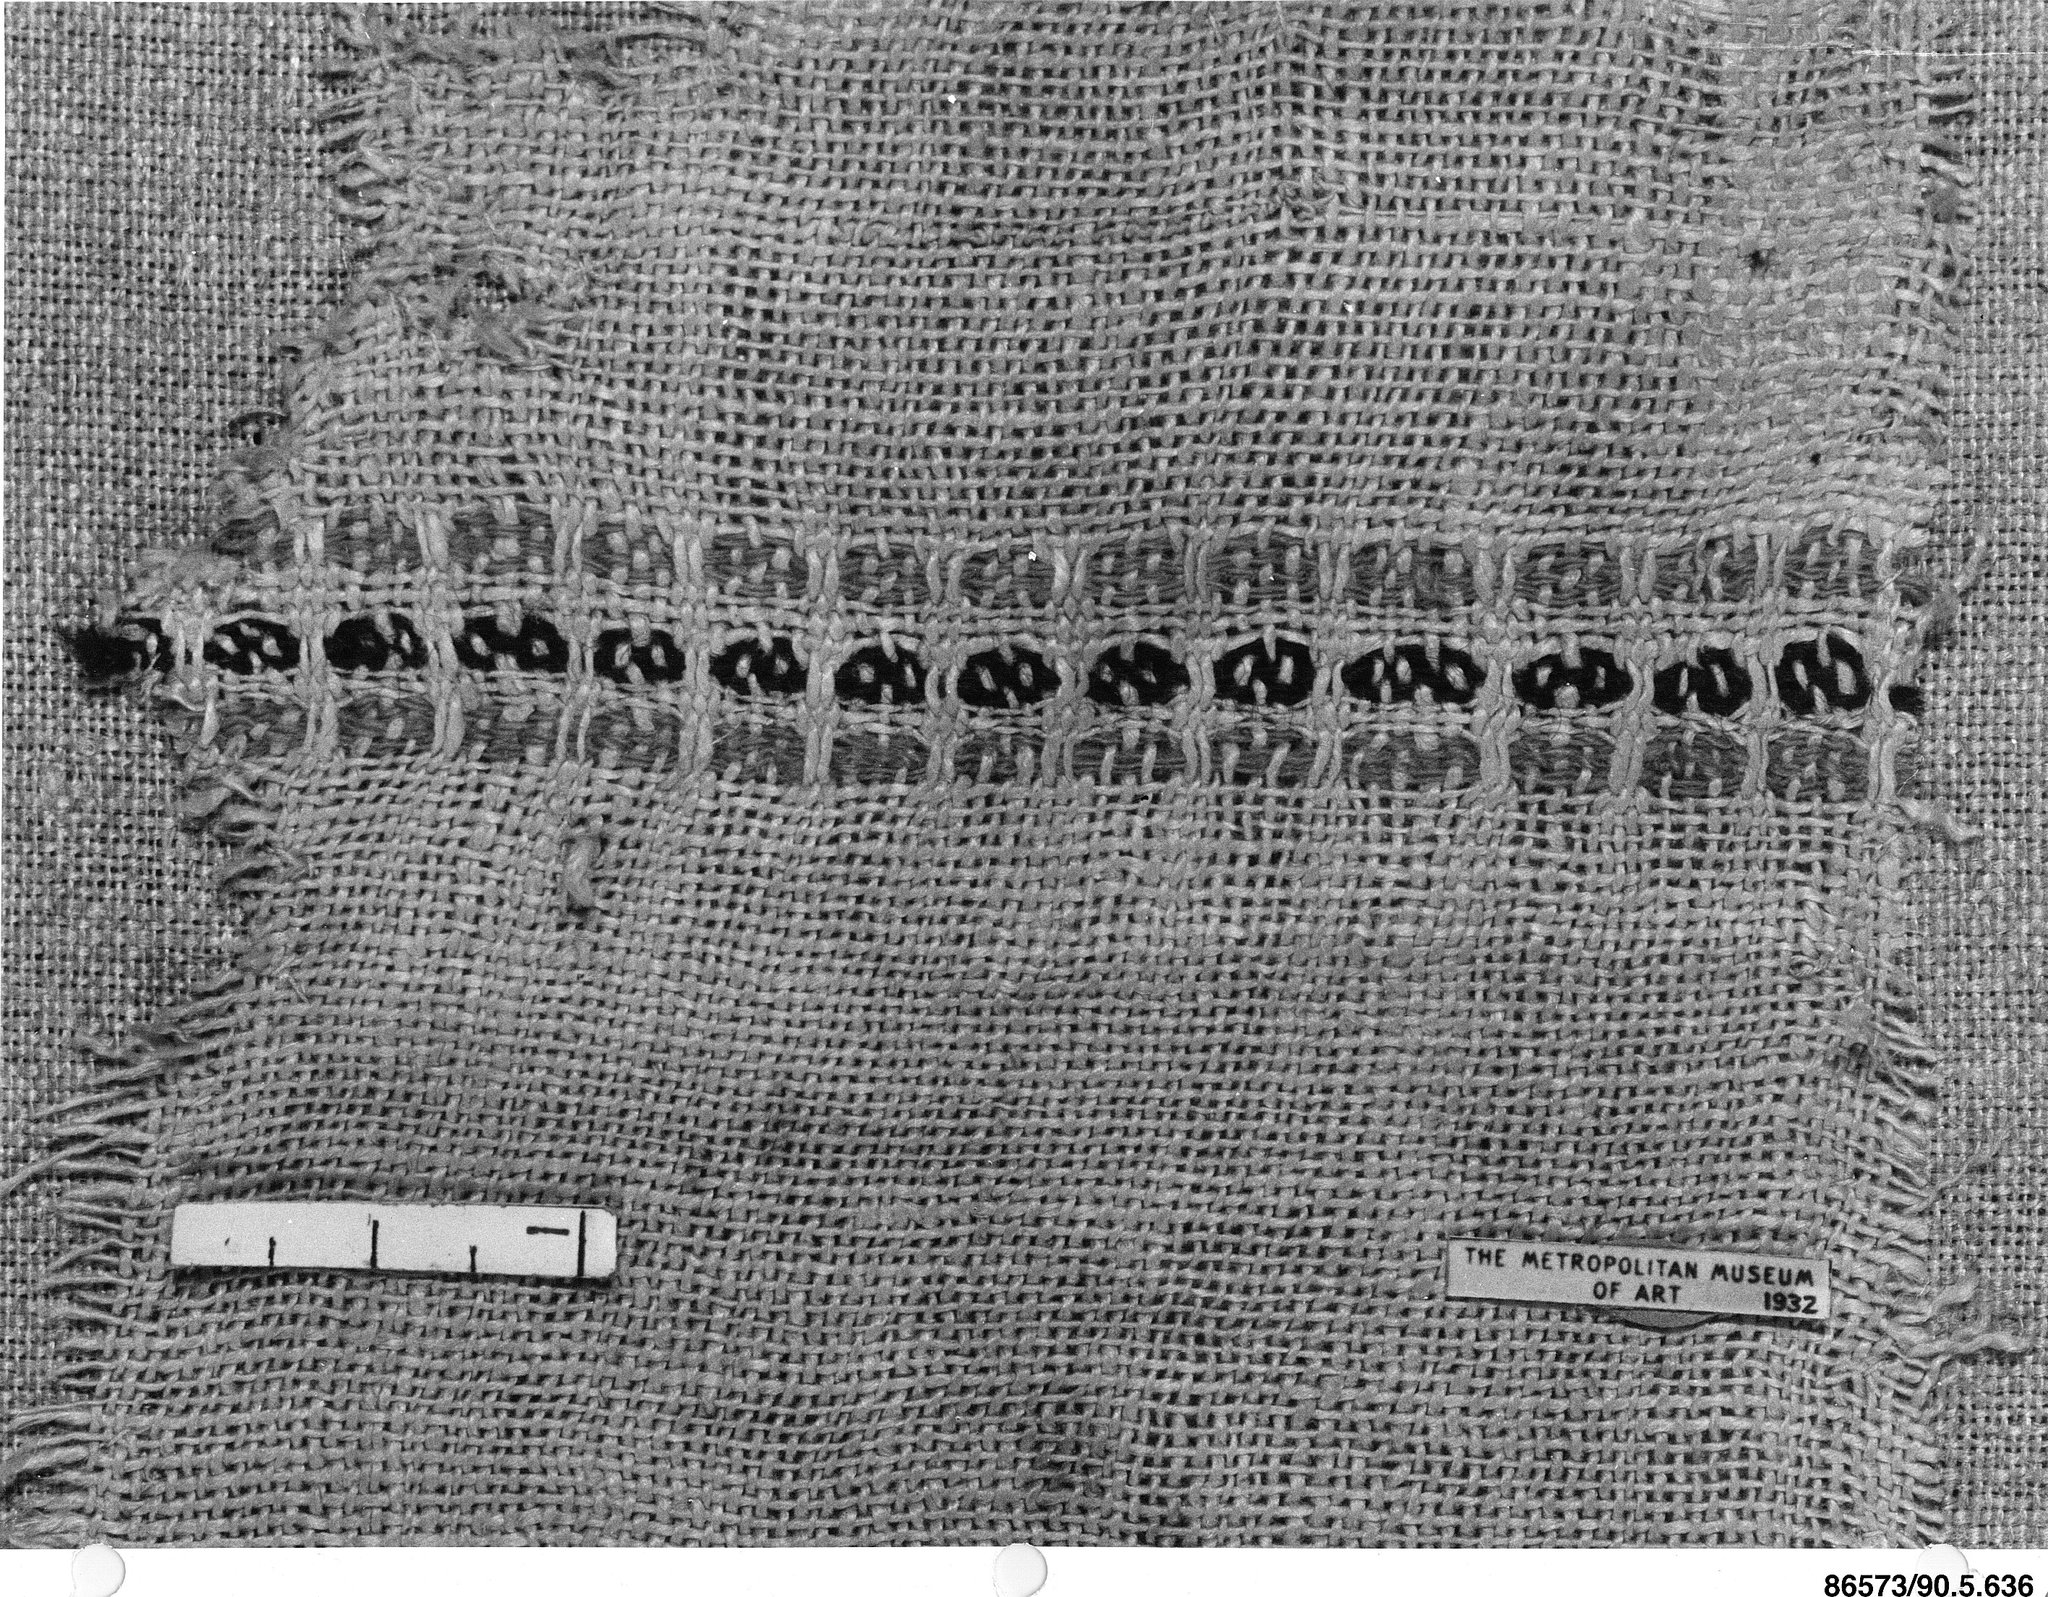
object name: textile fragment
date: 401-600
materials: linen, wool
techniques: weave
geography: egypt